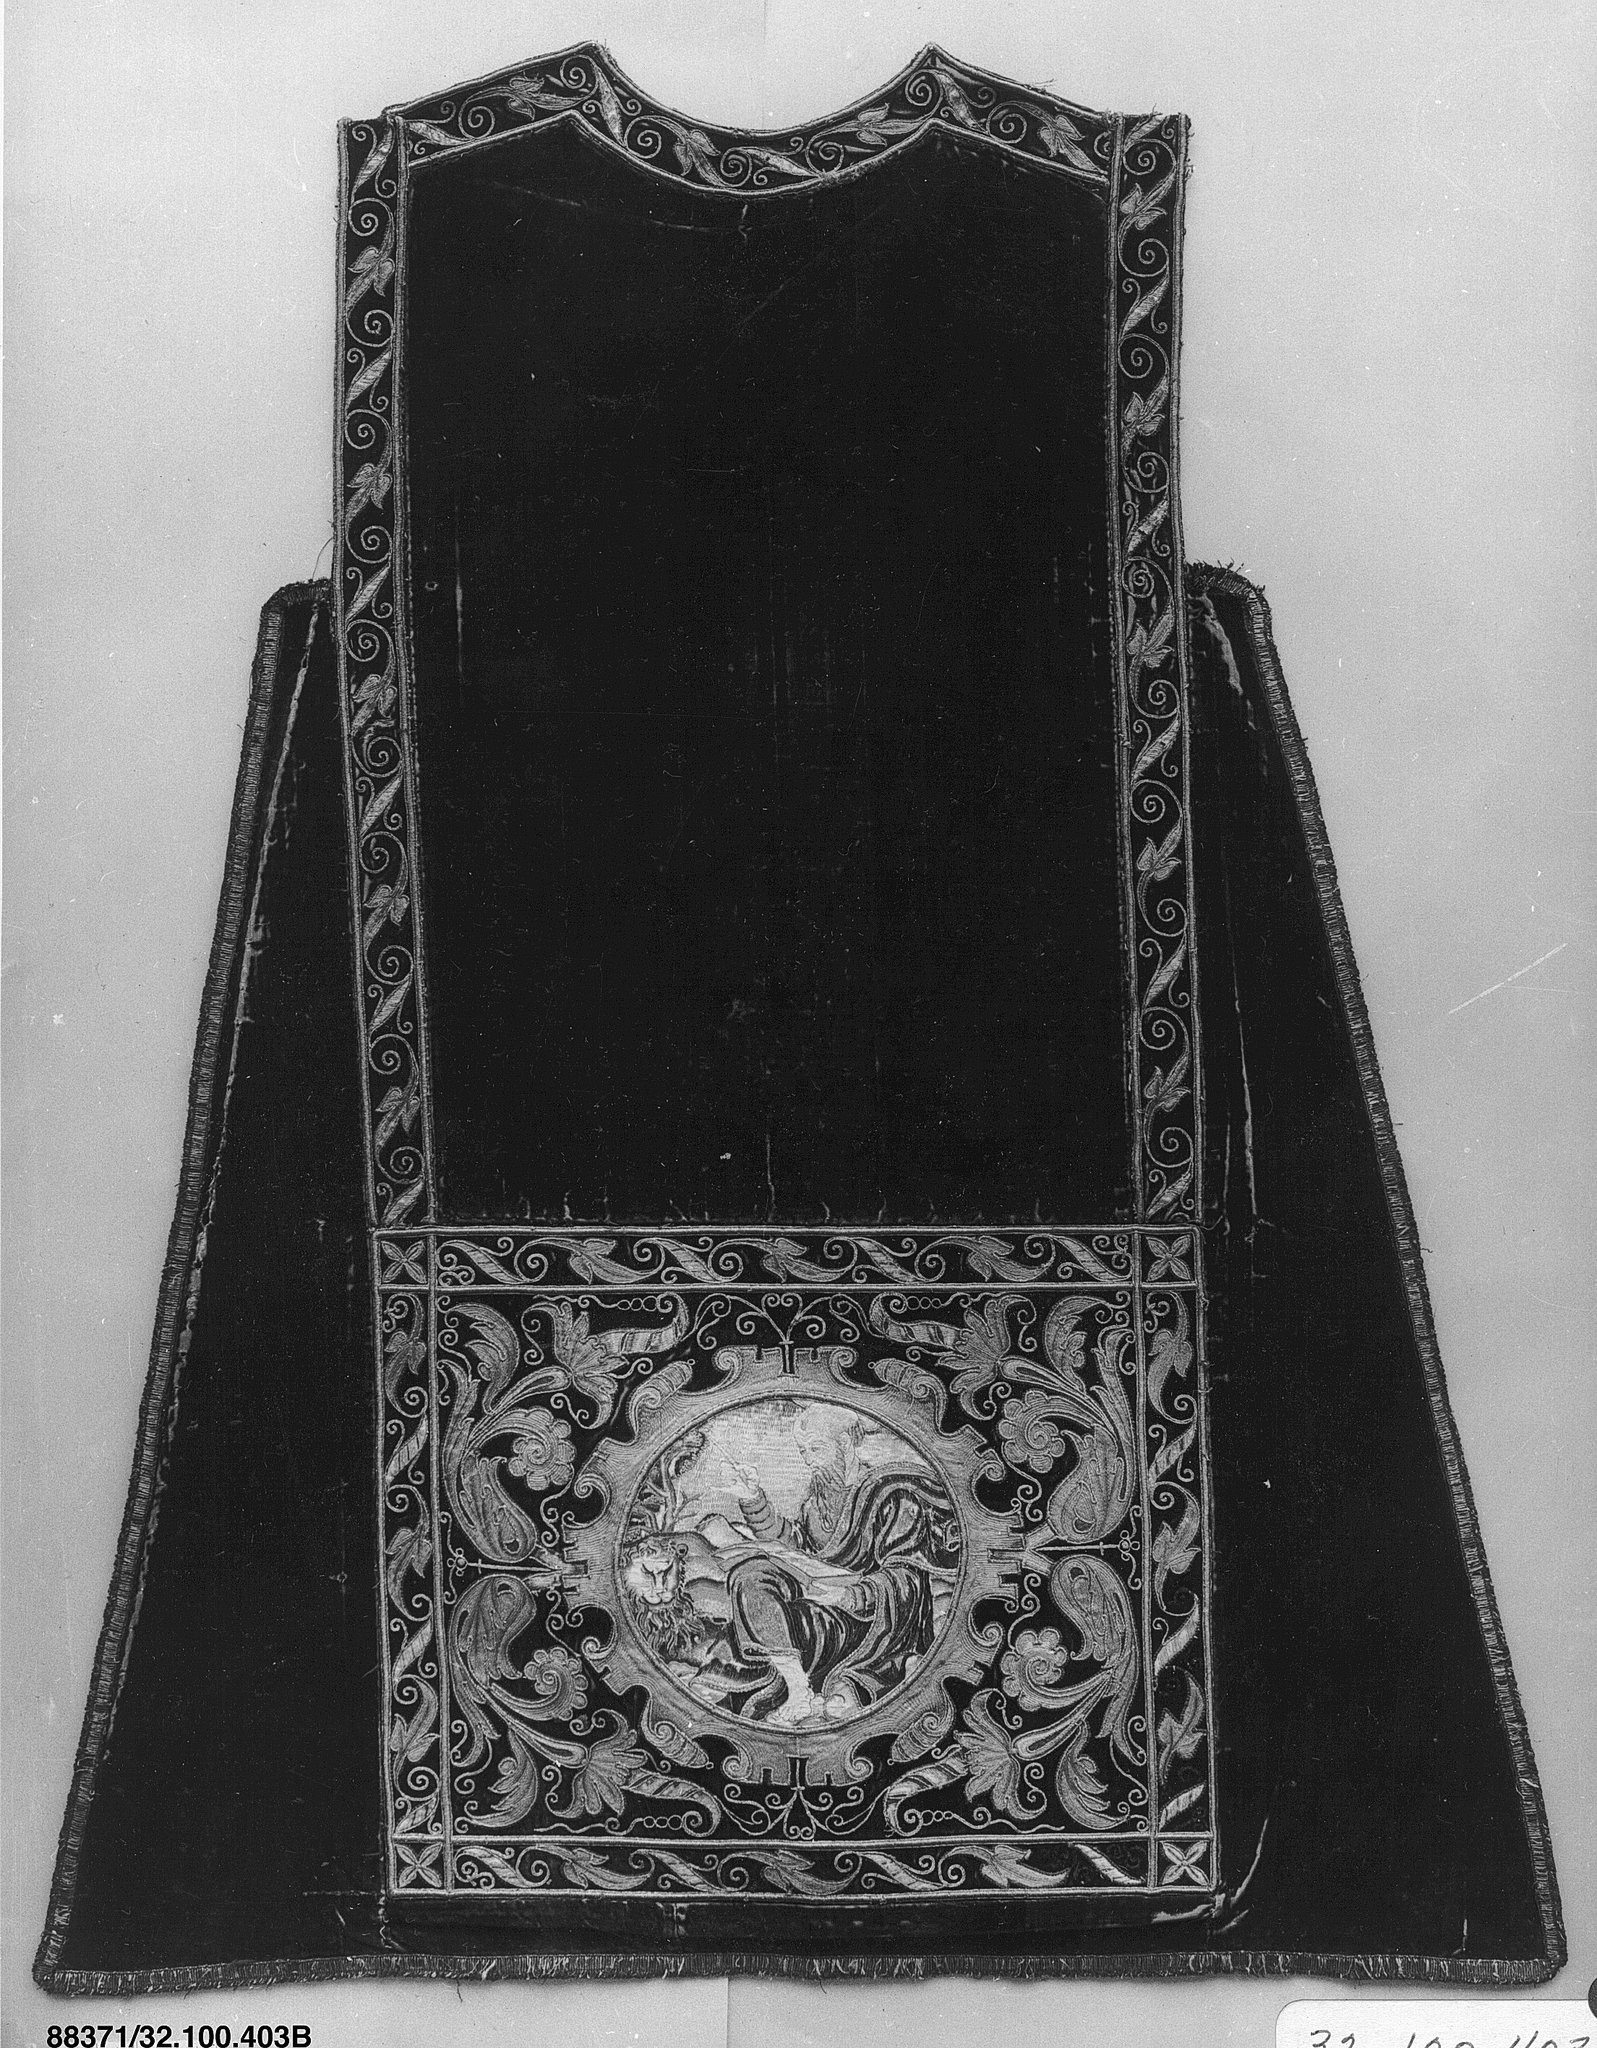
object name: dalmatic fragment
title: Dalmatic back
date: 1867-1900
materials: metal thread, silk